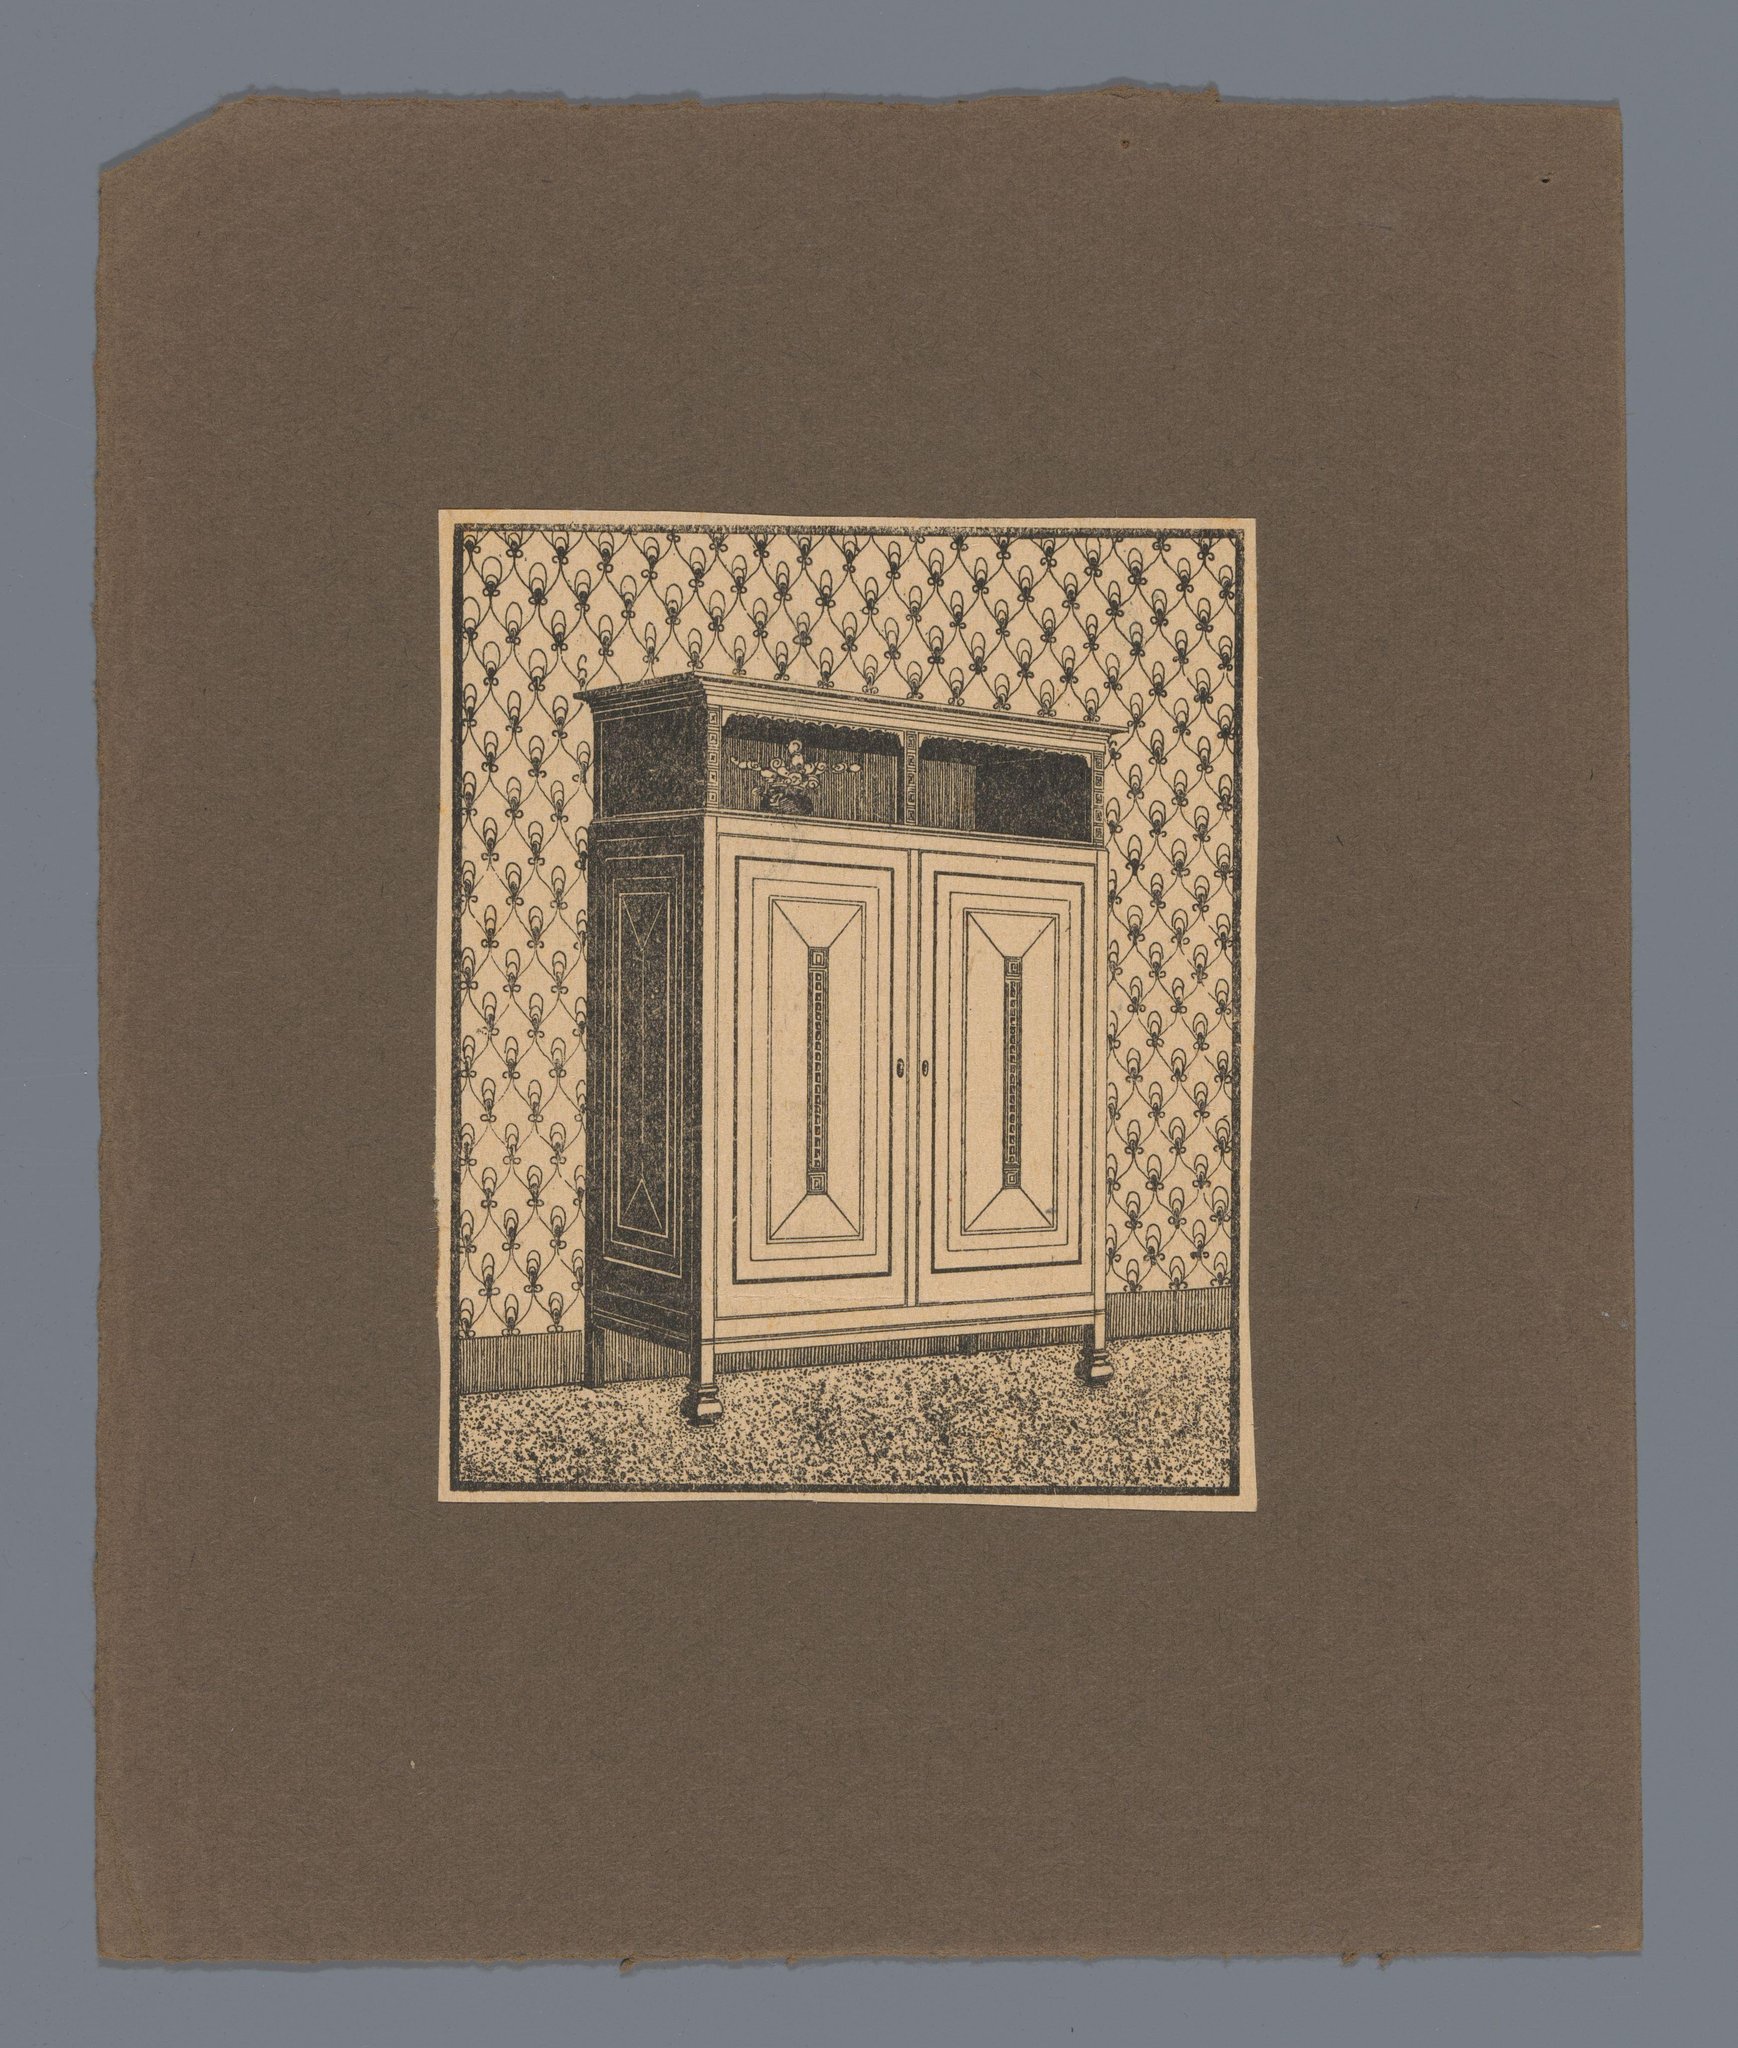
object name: print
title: Kast voor een geornamenteerd behang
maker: Anonymous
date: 1900-1921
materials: paper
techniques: lithograph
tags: cupboard